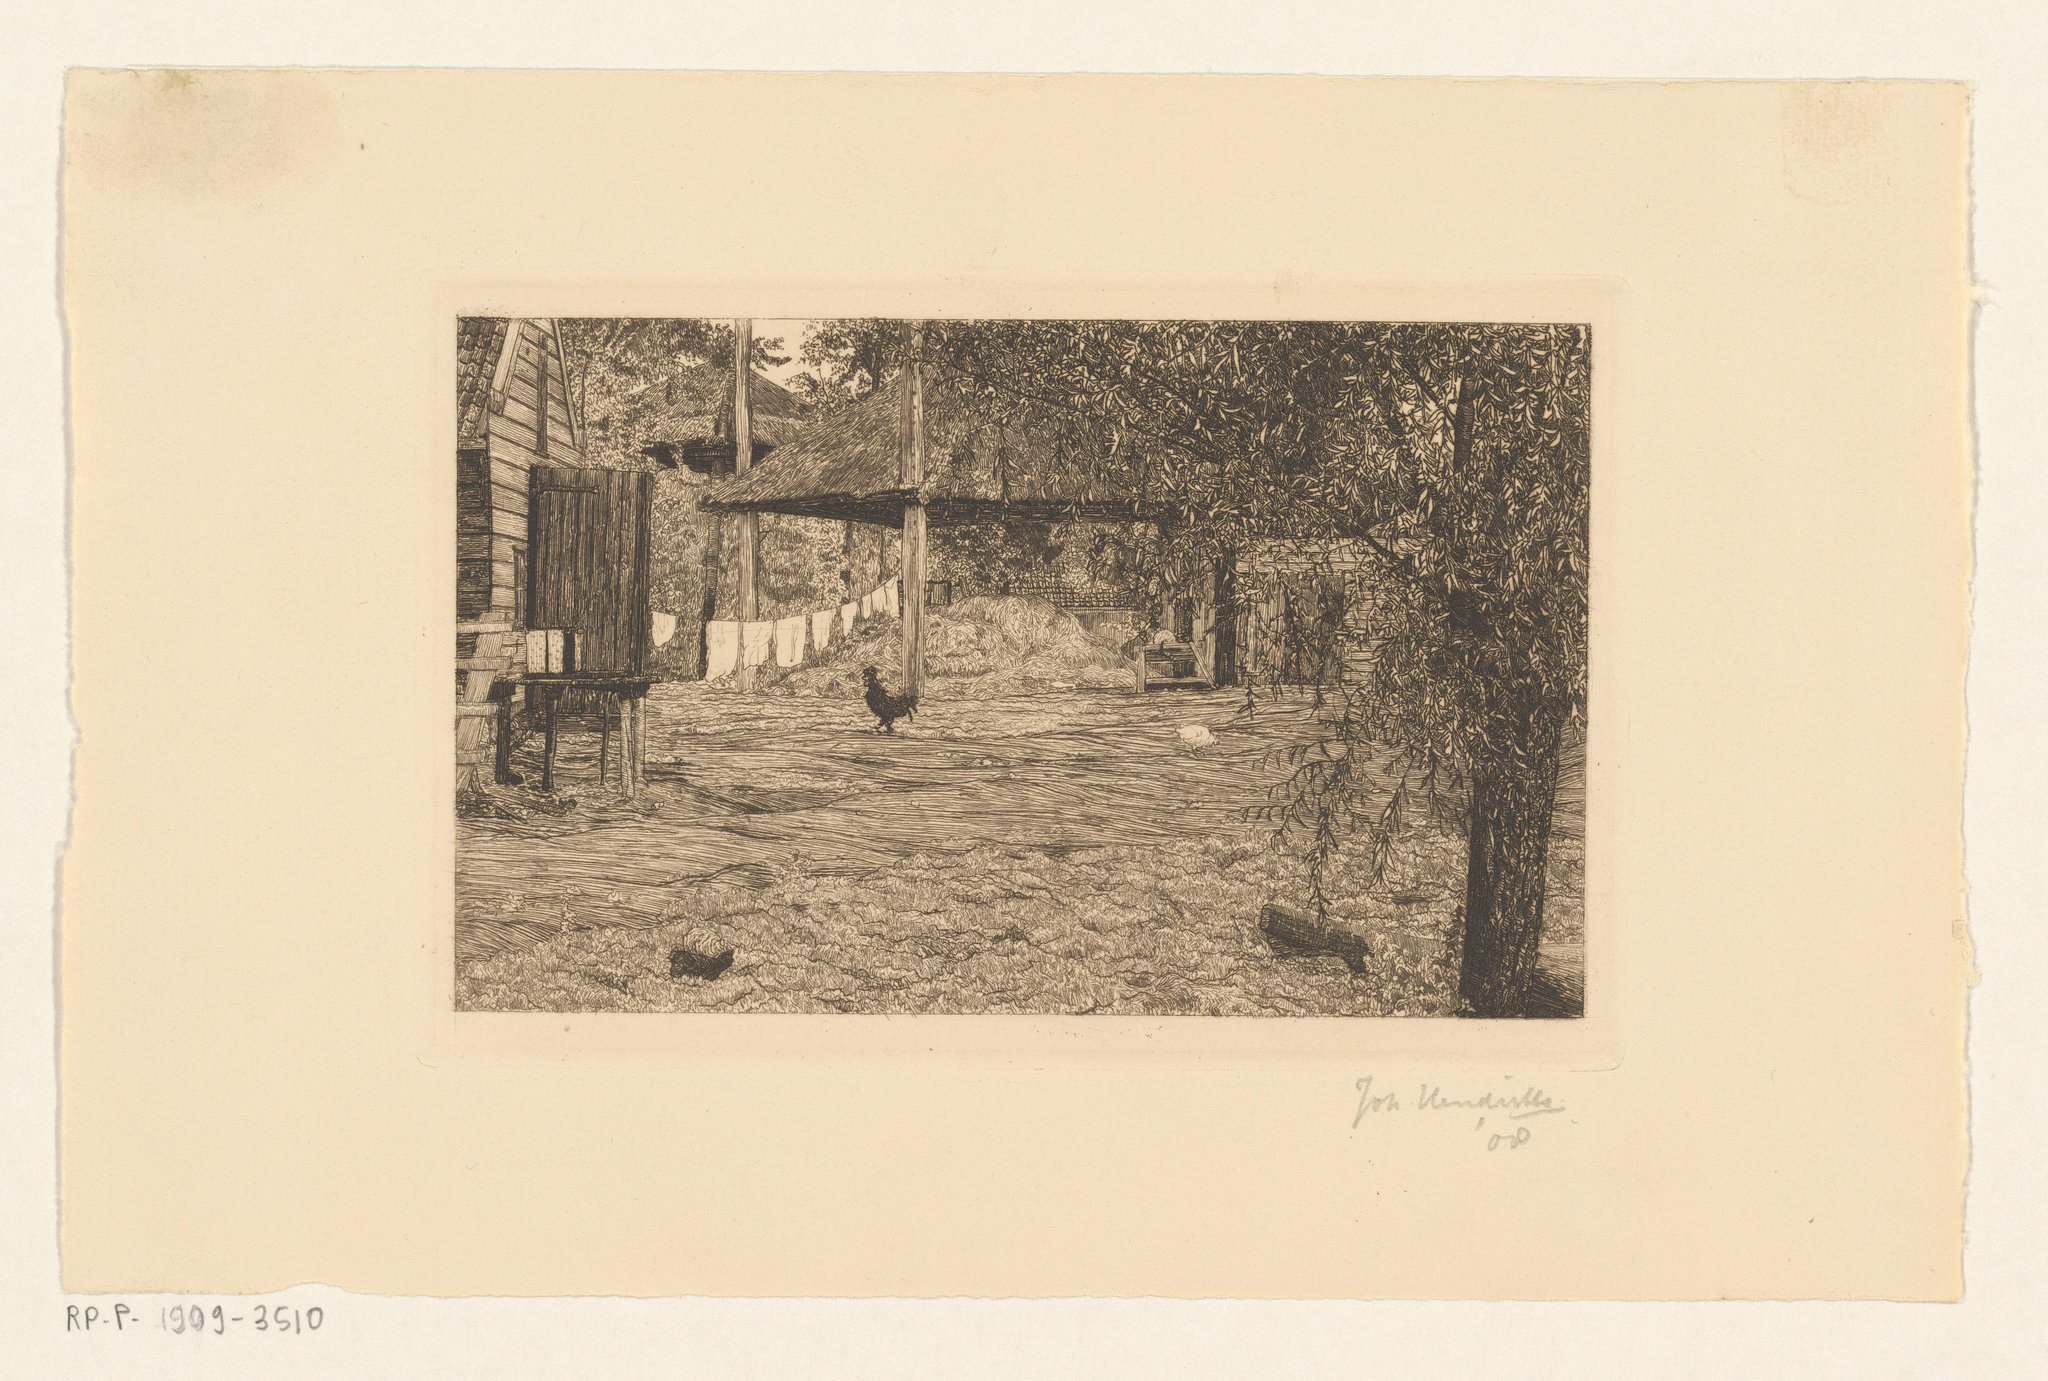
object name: print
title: Boerenerf met hooischuren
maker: johannes henrichs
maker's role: print maker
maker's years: 1882-1954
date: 1908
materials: paper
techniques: etching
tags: barn, hanging the wash to dry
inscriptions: collector's mark: Lugt 2228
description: Aan één van de hooischuren is een waslijn met kleding gespannen. Voor de waslijn loopt een haan.